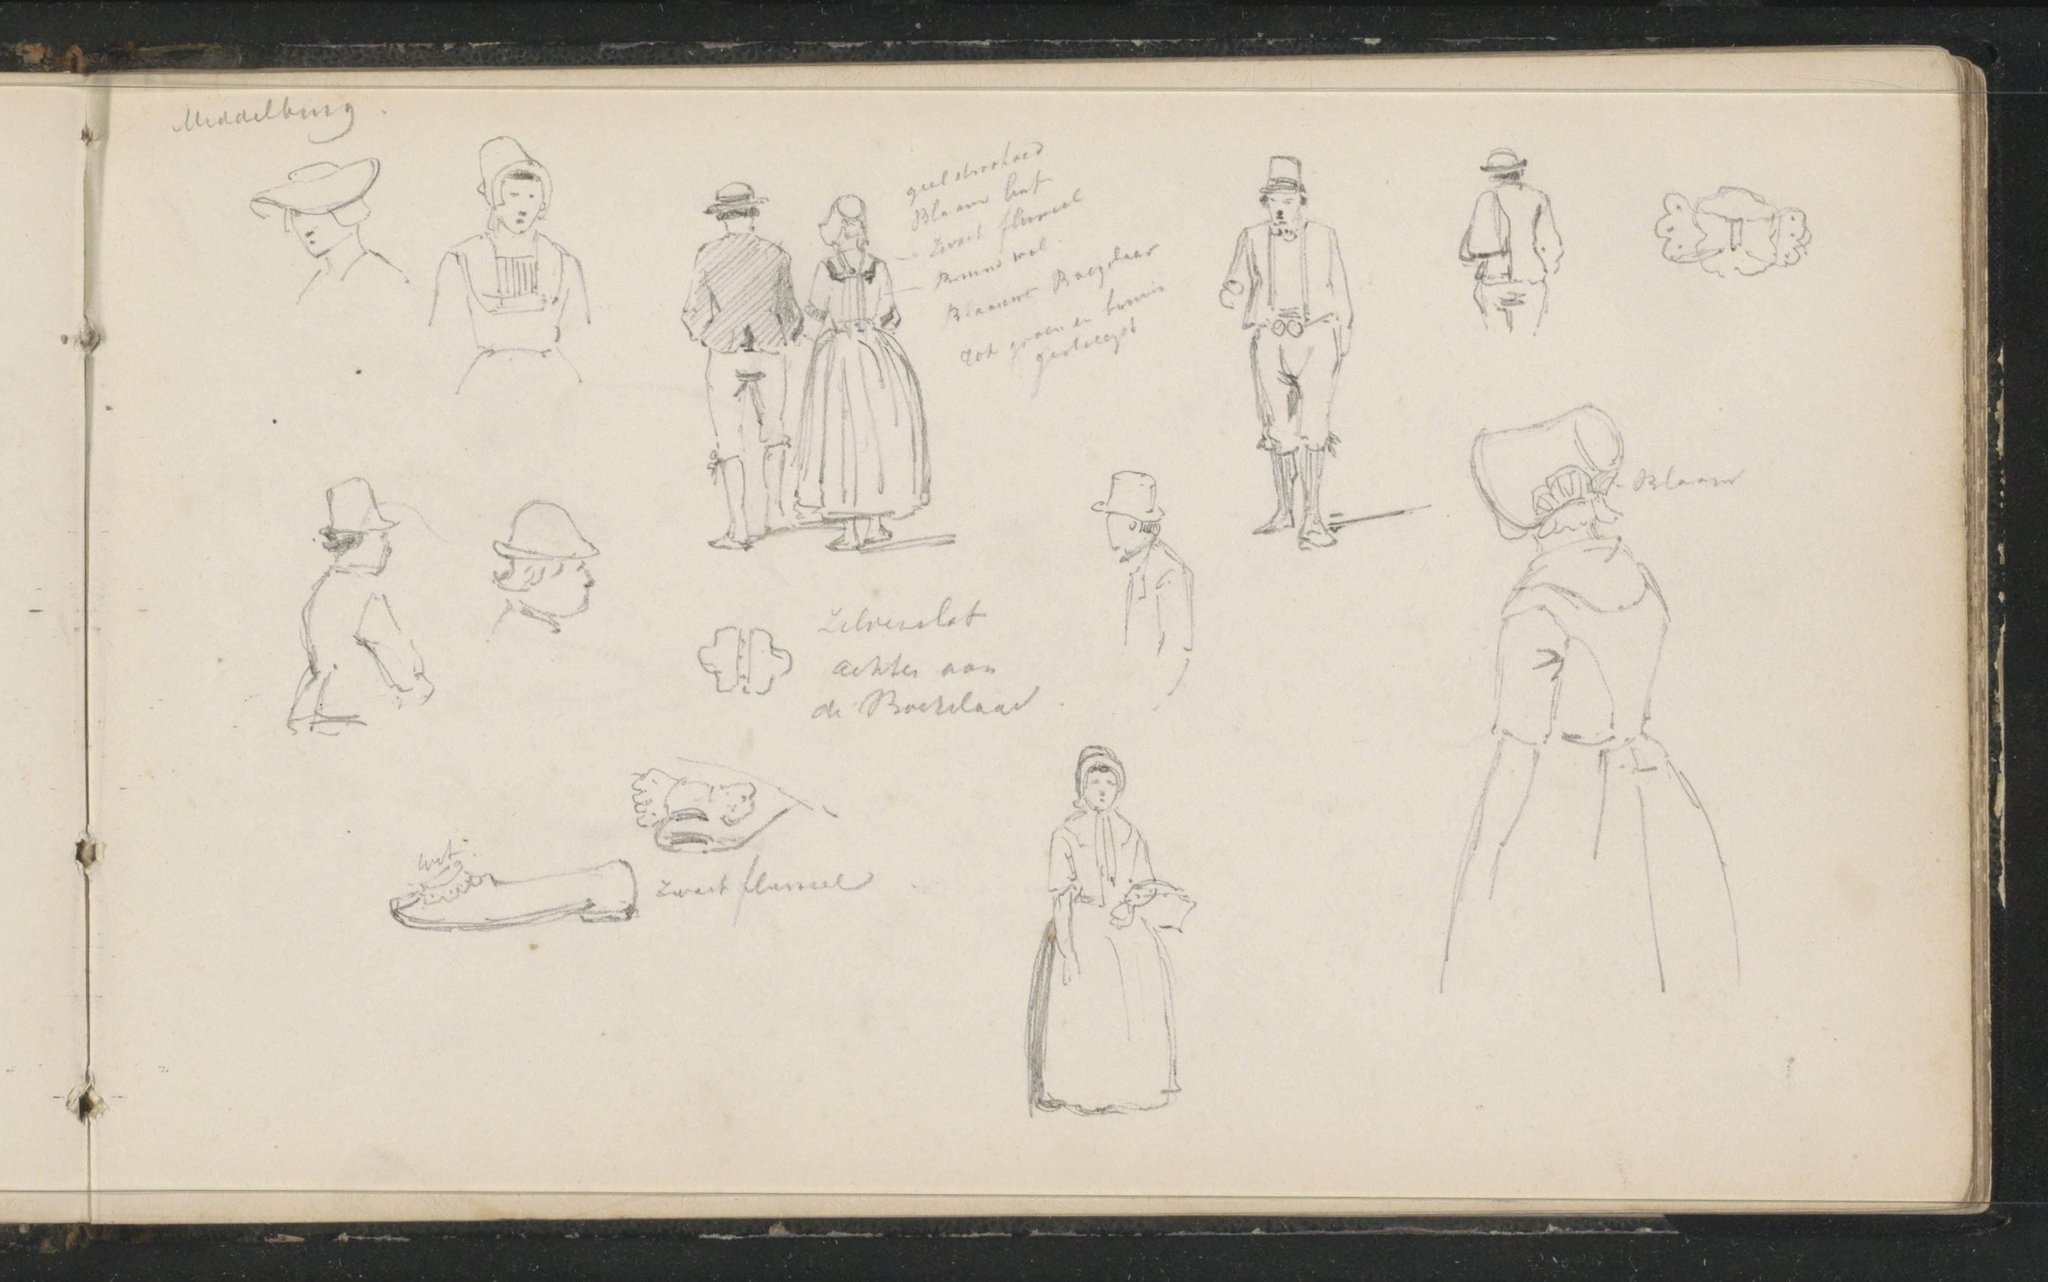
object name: sketchbook leaf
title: Middelburgse kostuumstudies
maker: cornelis springer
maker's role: draughtsman, painter, print maker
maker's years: 1817-1891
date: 1856-1861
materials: paper, pencil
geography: middelburg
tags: head-gear, accessories (~ clothing), clothes, costume, middelburg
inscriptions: annotation: ‘Middelburg’, annotation: ‘geel stroohoed/ Blaauw lint/ Zwart fluweel/ Bruine wol/ Blaauw [...]/ rok groen en bruin/ gestreept/ Zilverslot/ achter aan/ de [...]/ zwart fluweel’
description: Studies van Middelburgse kostuums, hoeden en accessoires. Blad 3 uit een schetsboek met 44 bladen vervaardigd in Zeeland en Utrecht.